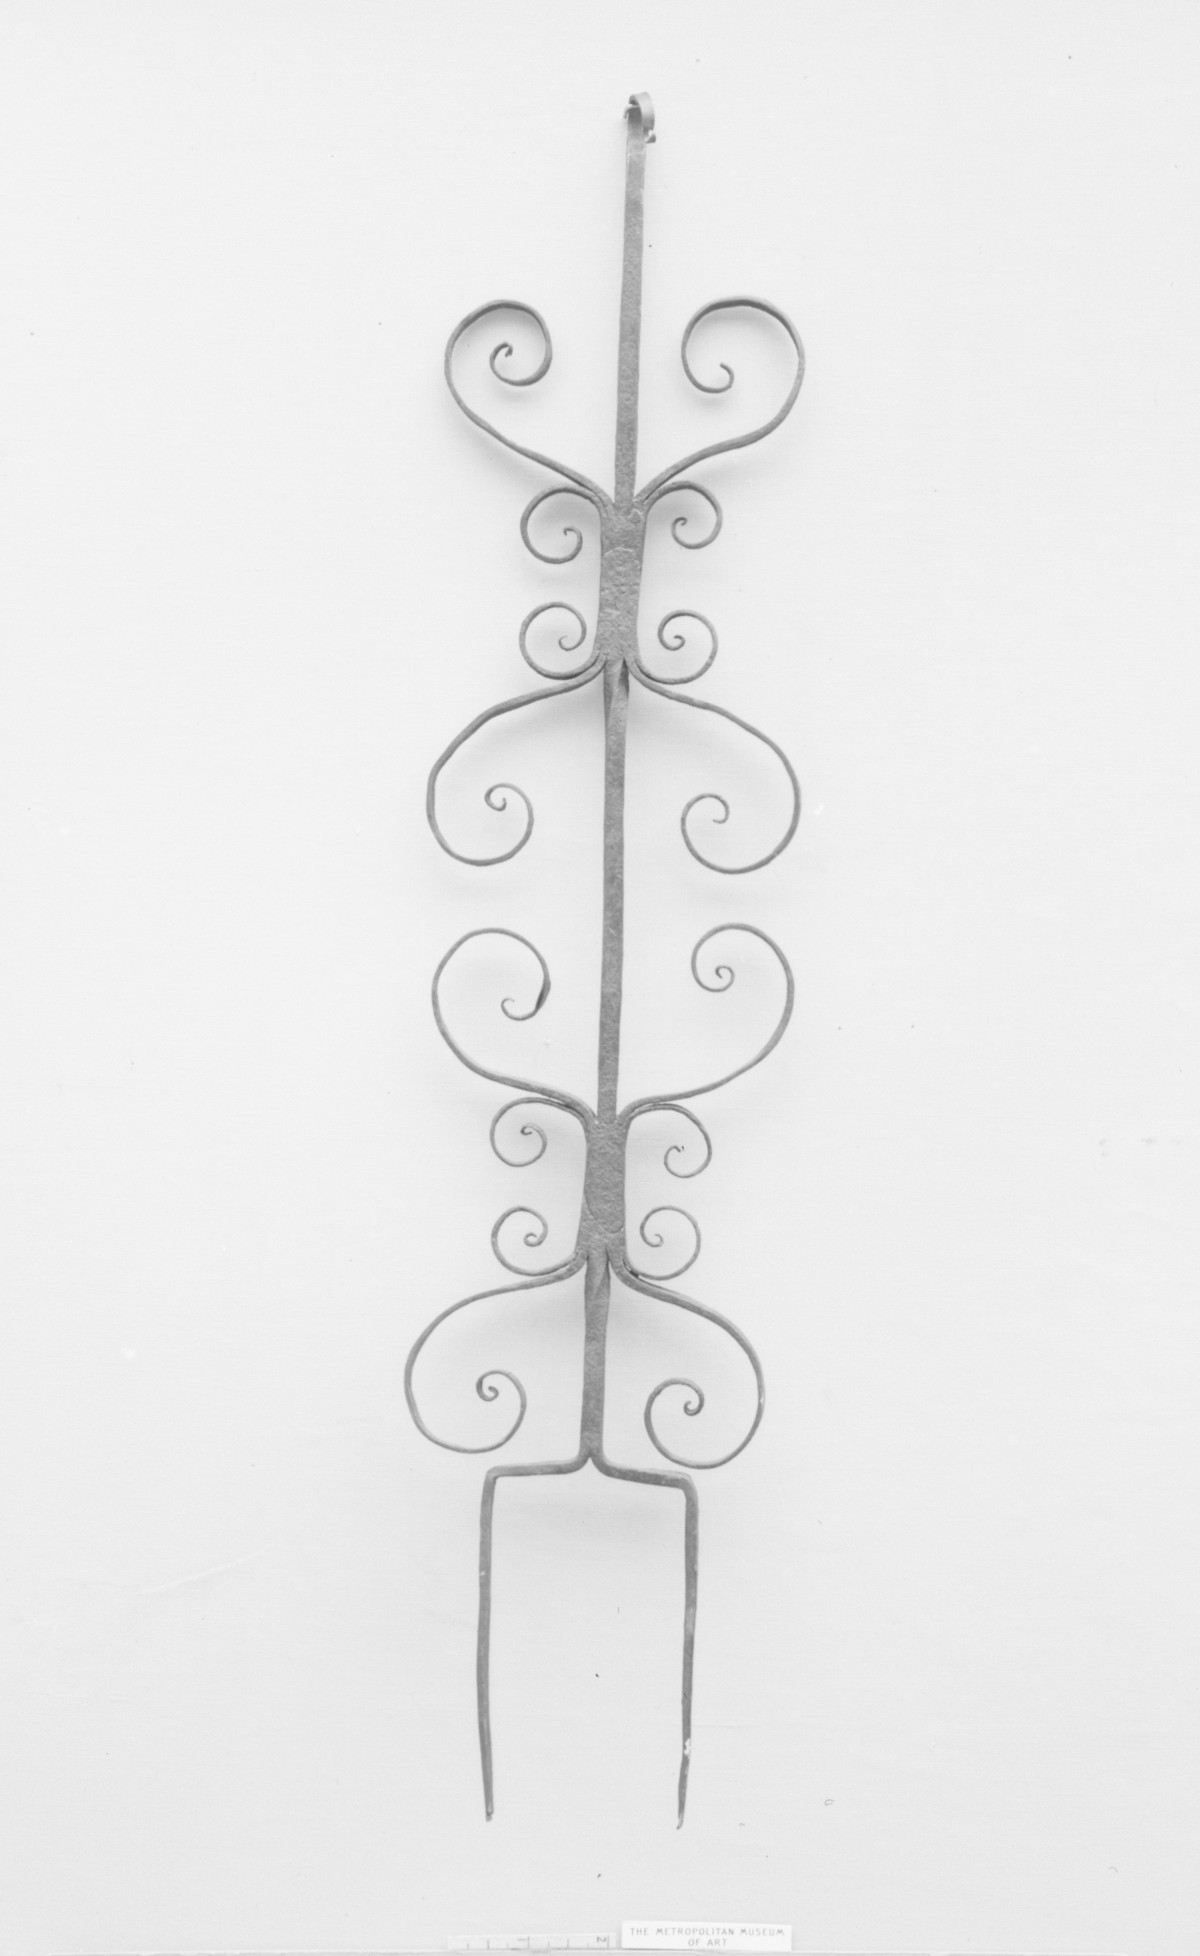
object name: fork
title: Broiling or toasting fork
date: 1601-1700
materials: iron